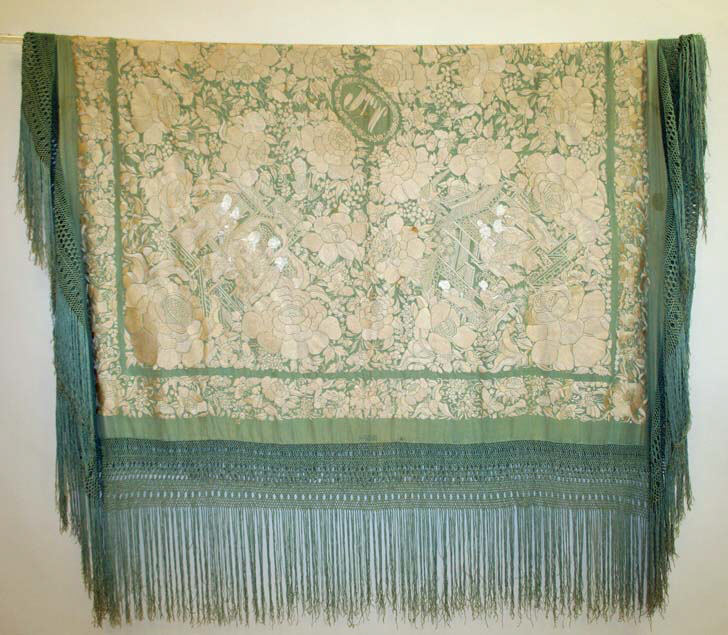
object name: shawl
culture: american or european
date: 1834-1866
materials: silk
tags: human figures